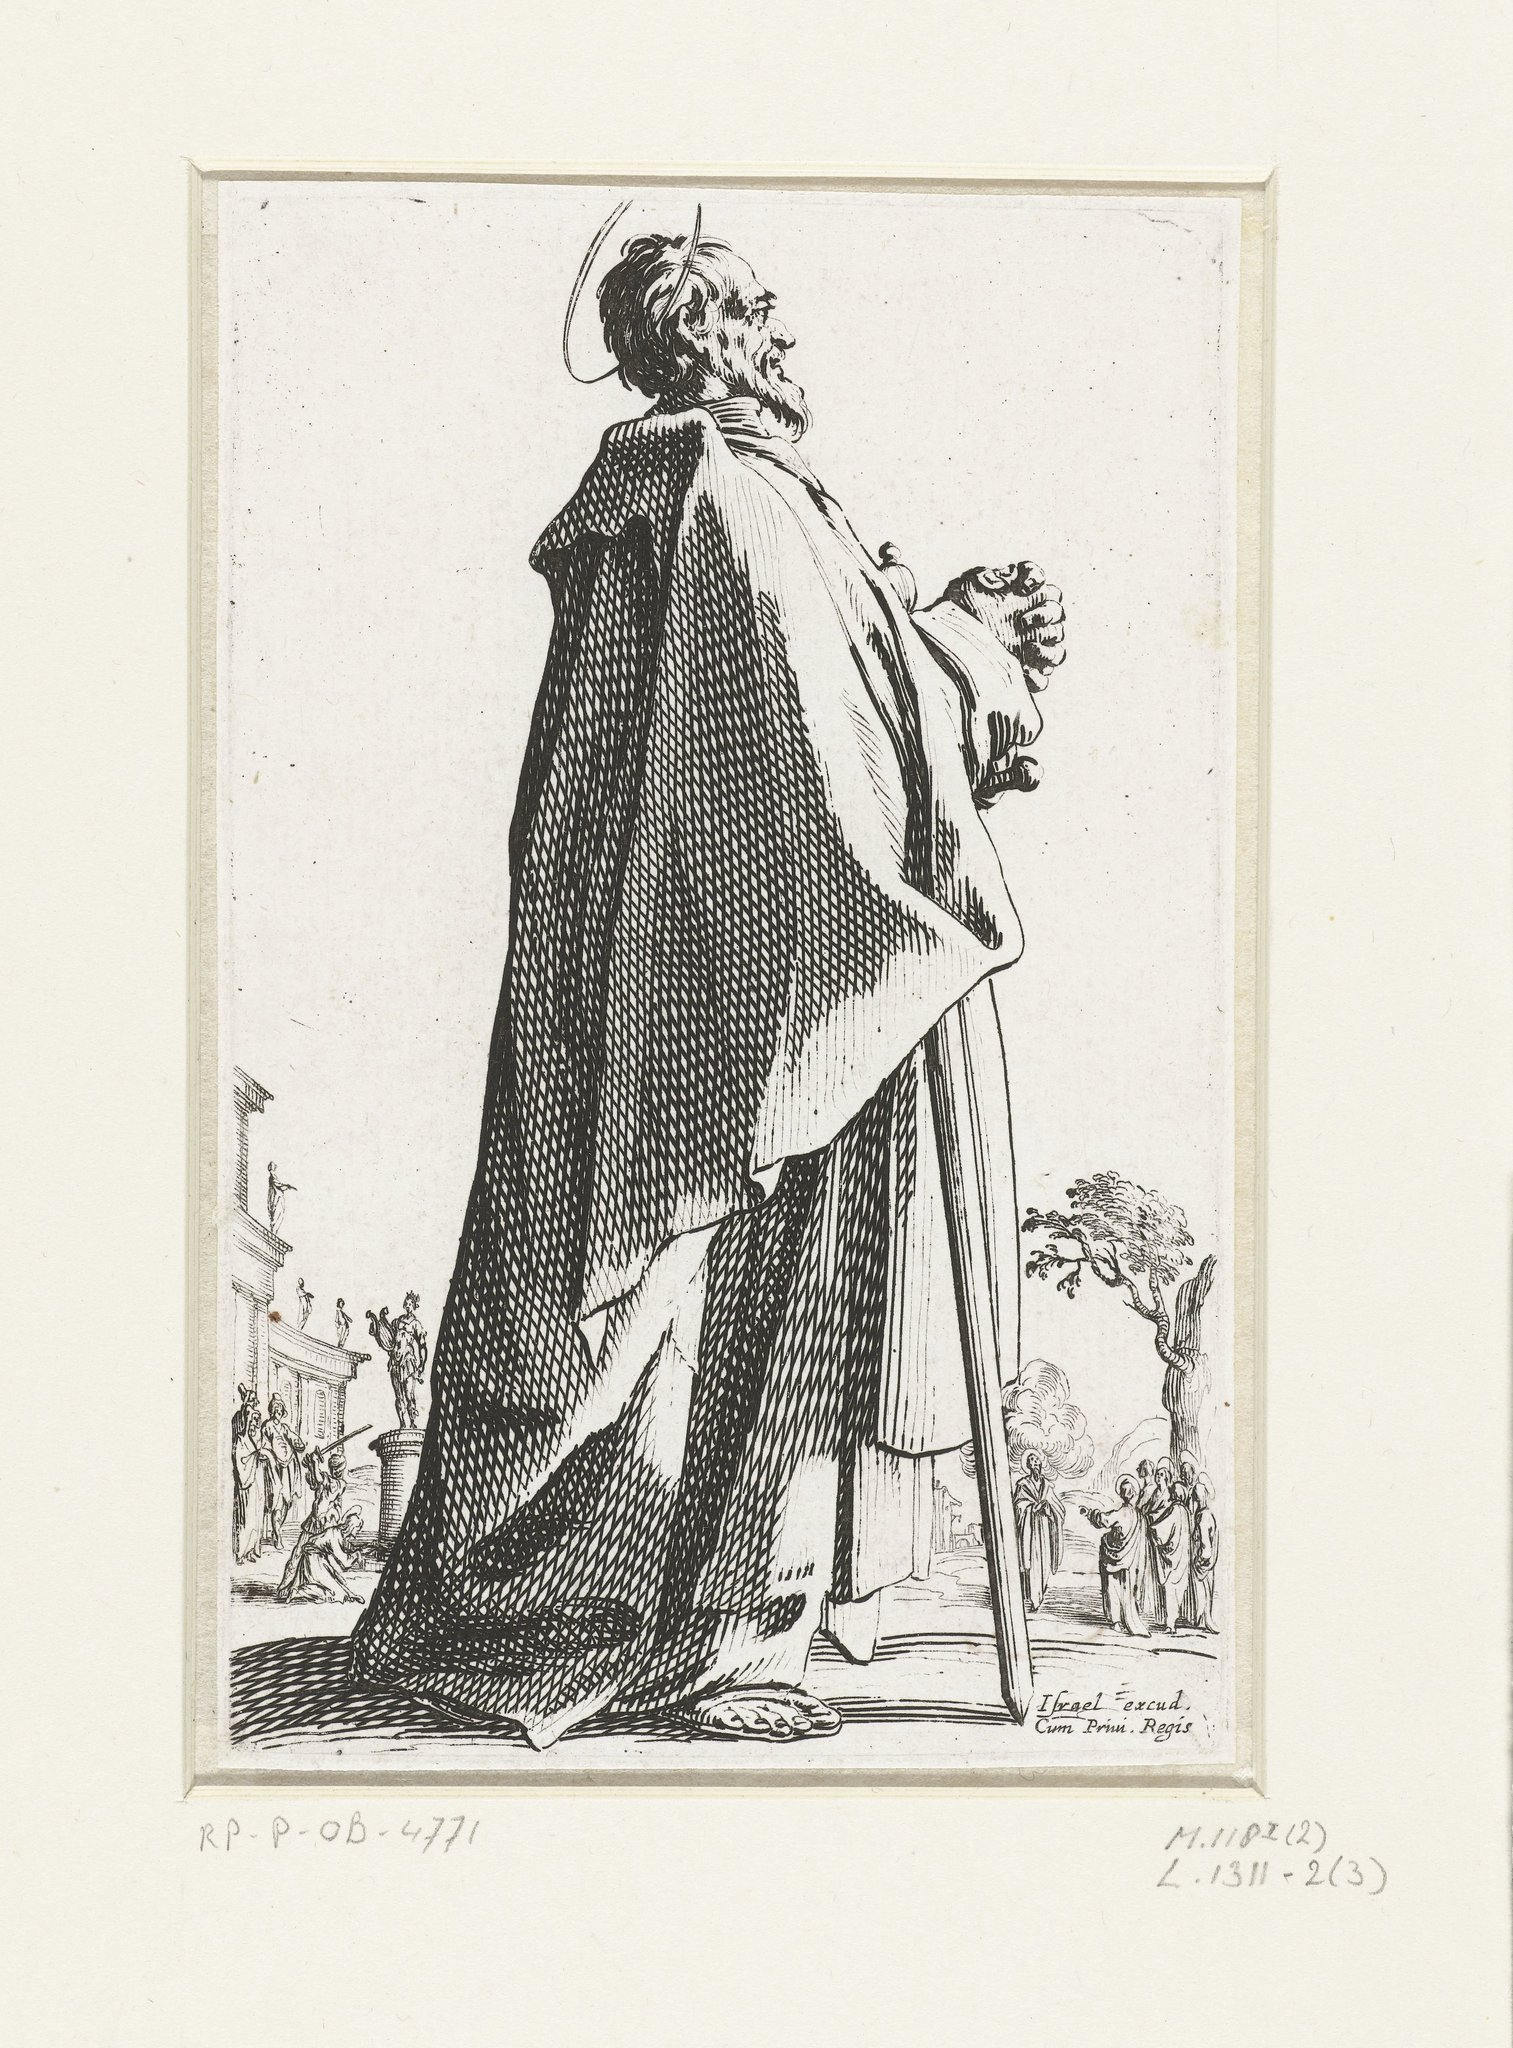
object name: print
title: De grote apostelen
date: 1631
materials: paper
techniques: etching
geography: nancy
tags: the apostle and evangelist matthew (mattheus); possible attributes: angel, axe, book, halberd, pen and inkhorn, purse, scroll, square, sword, matthew is slain before an altar by soldiers of hirtacus and is beheaded, calling of matthew (levi), the tax-collector (usually with money lying on the table and people paying taxes) (matthew 9:9; mark 2:14; luke 5:27-28)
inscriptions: collector's mark: Lugt 240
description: Mattheüs, ten voeten uit, steunend op een zwaard. Op de achtergrond rechts is te zien hoe Mattheüs door Christus geroepen wordt hem te volgen; op de achtergrond links is te zien hoe hij onthoofd wordt. Deze prent is onderdeel van een reeks van 16 prenten, bestaande uit een titelblad en 15 portretten, voorstellende Christus, Maria en de apostelen.